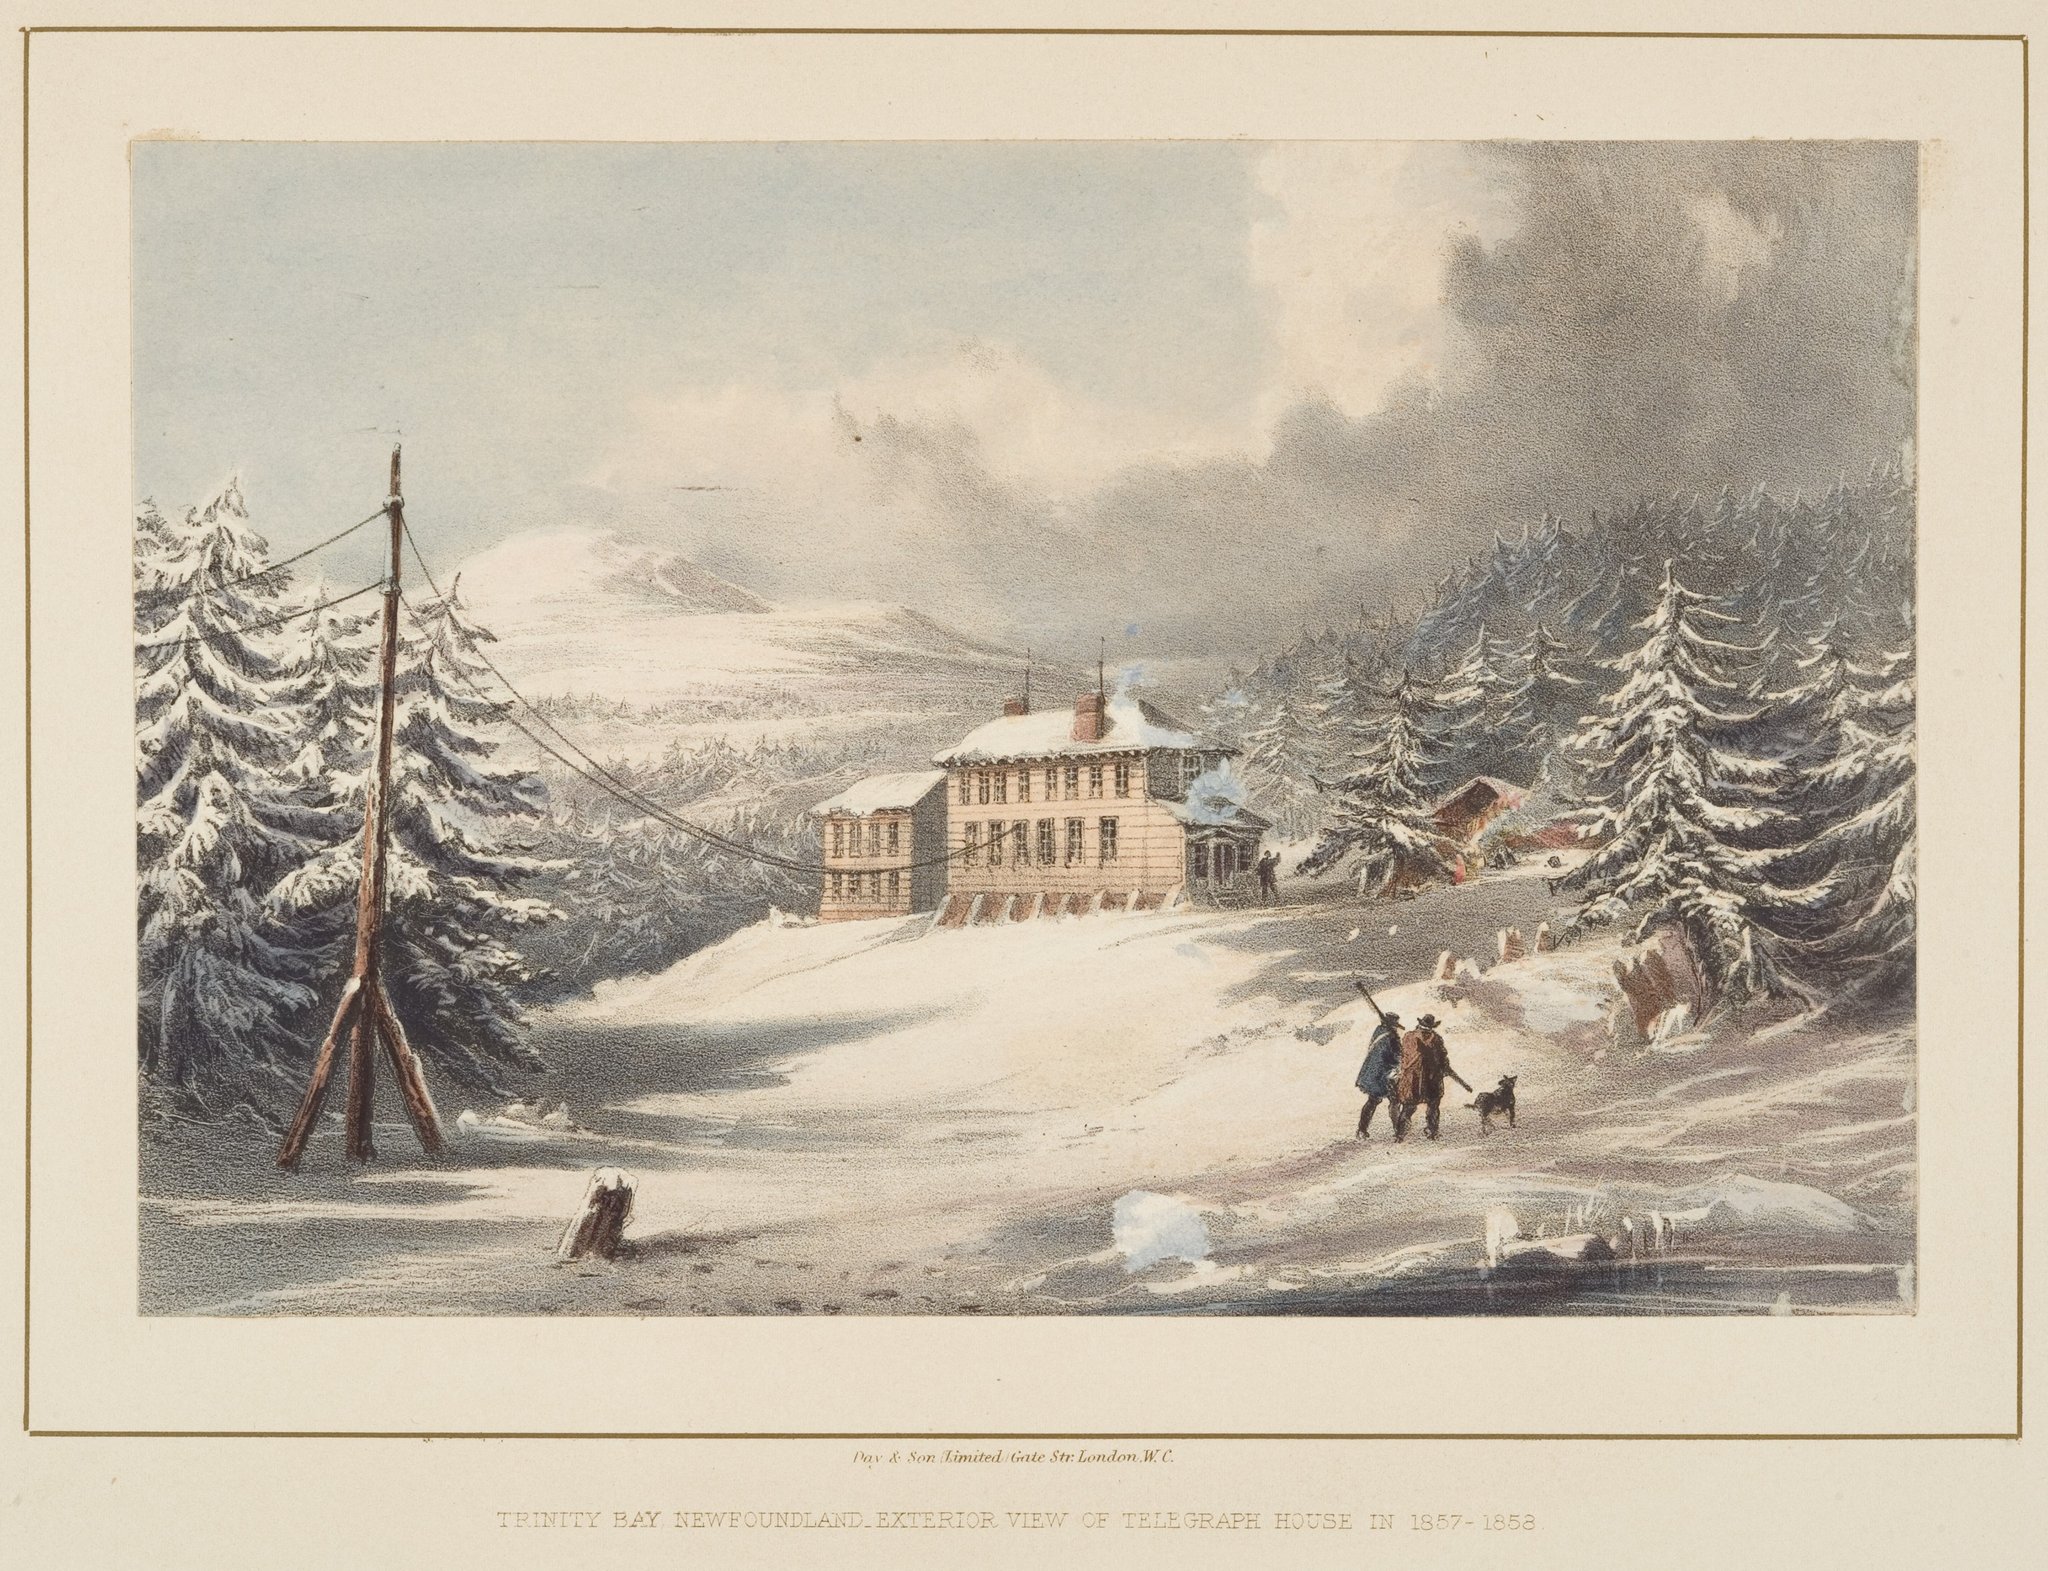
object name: book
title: The Atlantic Telegraph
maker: sir william howard russell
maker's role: author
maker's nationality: irish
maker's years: 1820-1907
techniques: lithograph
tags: human figures,houses,snow